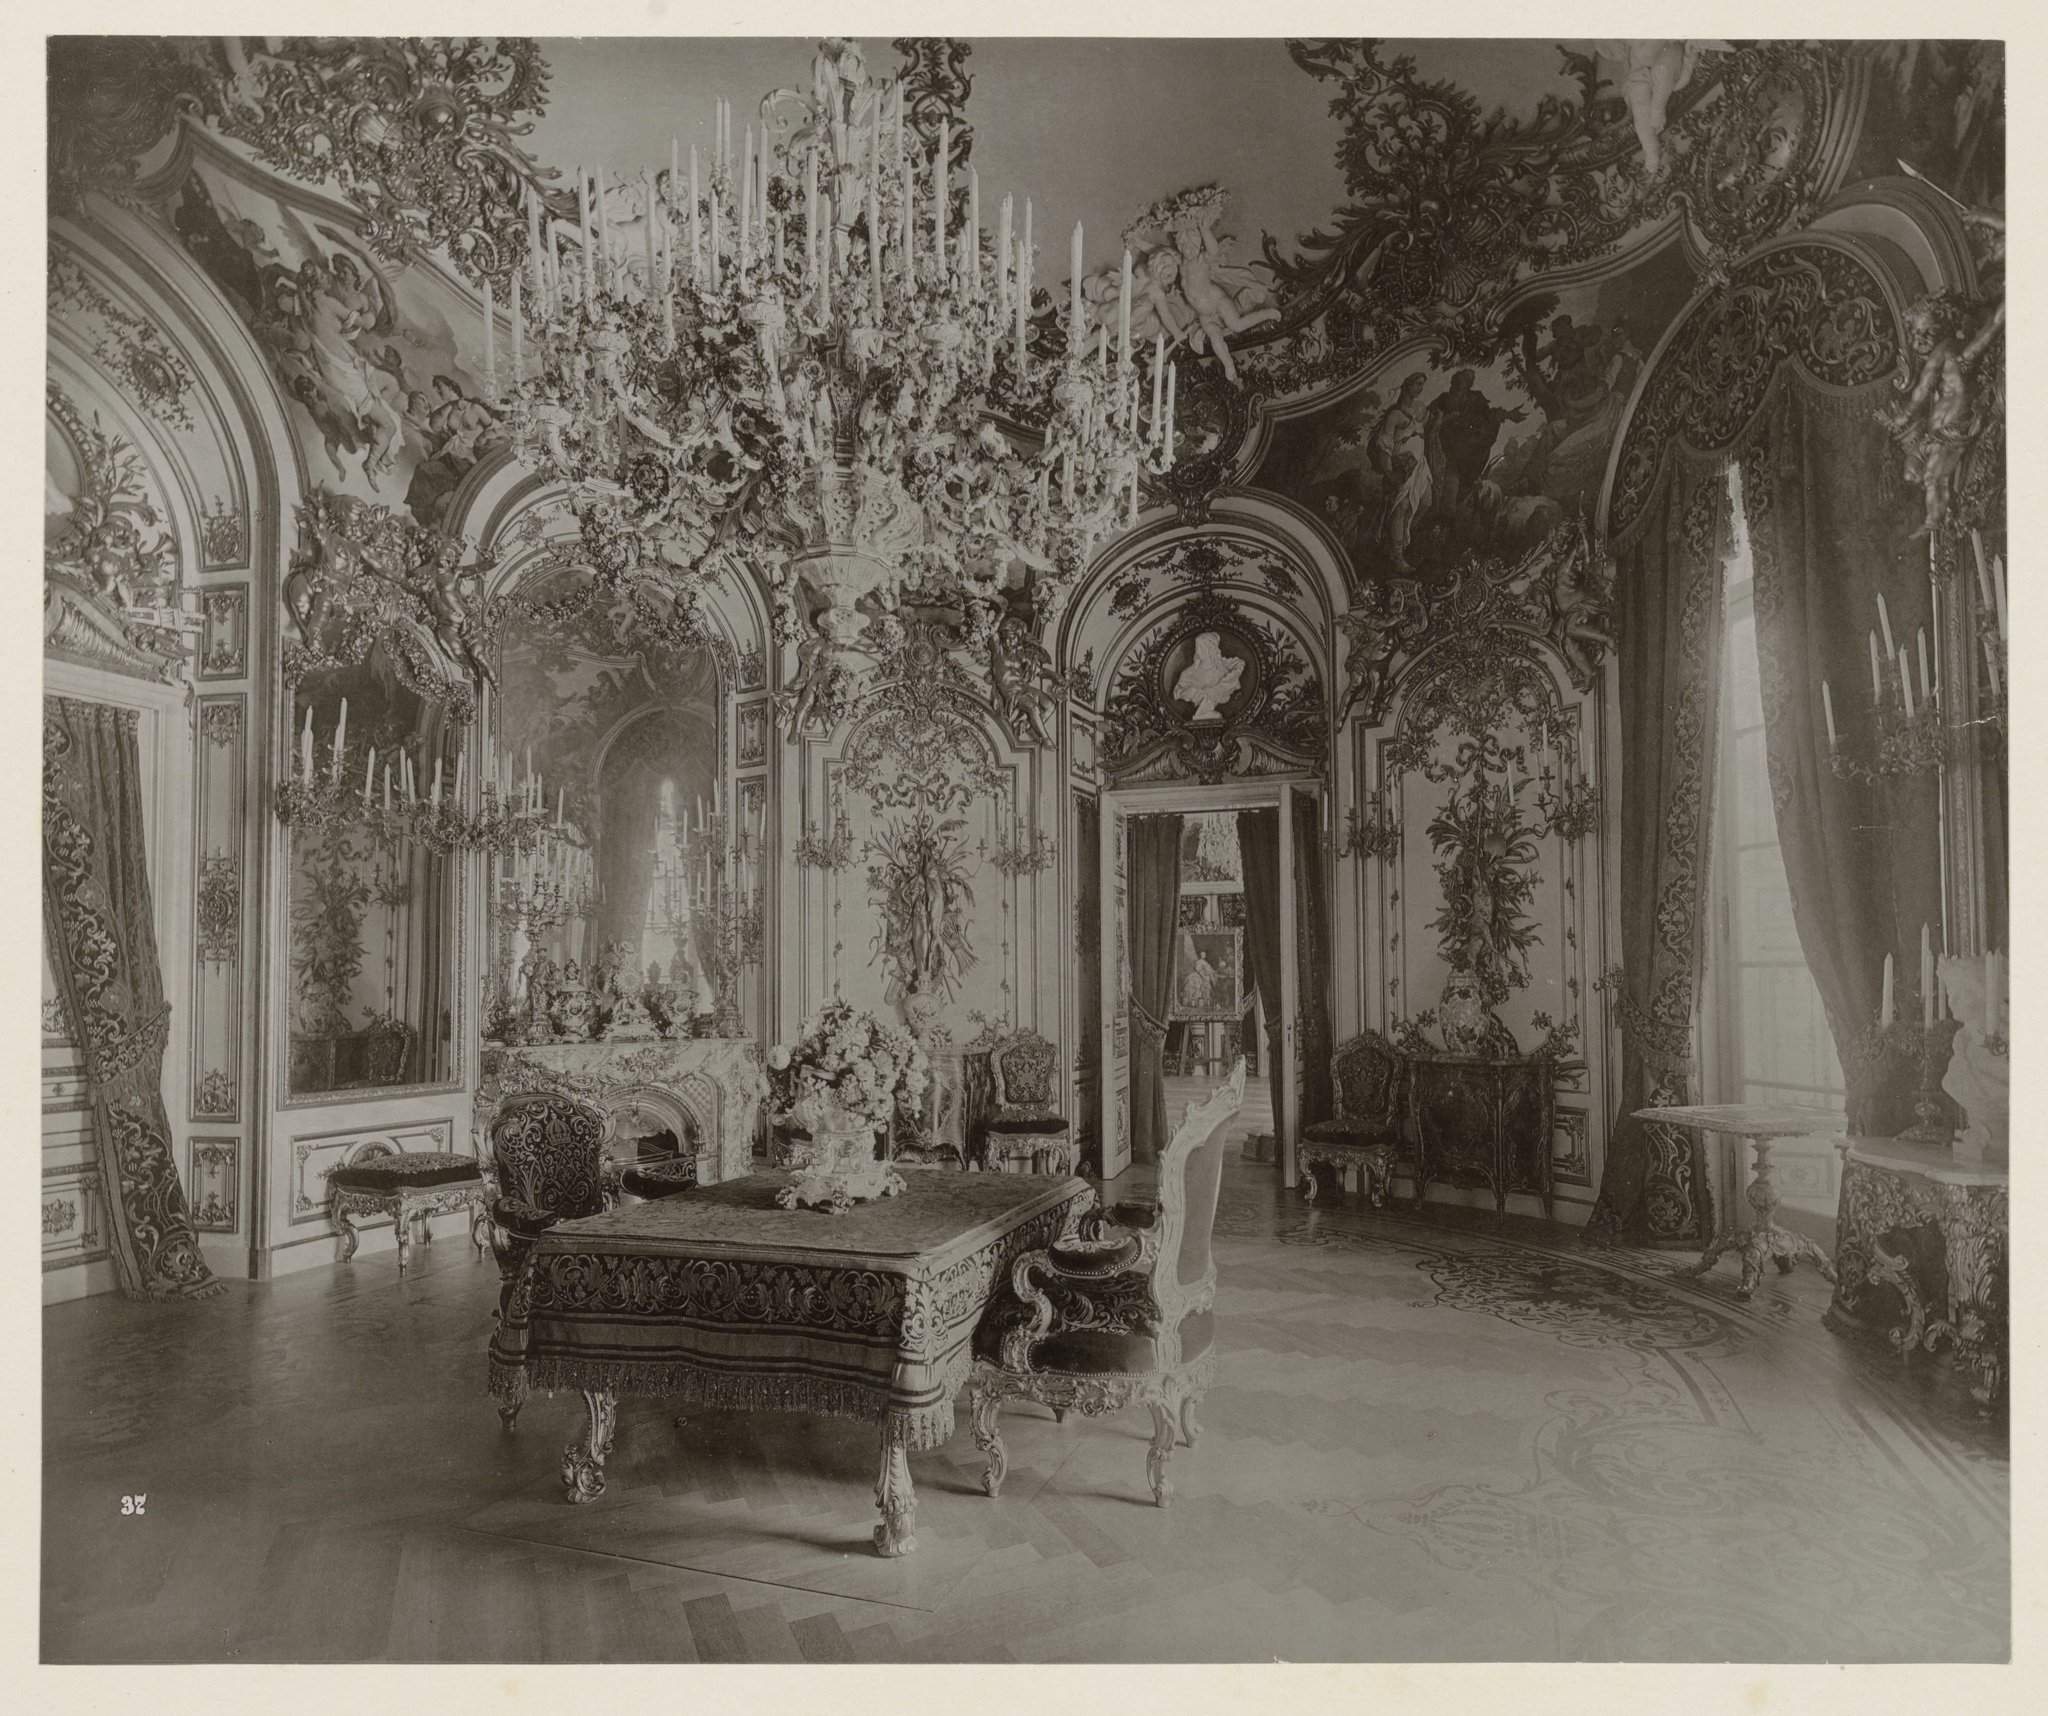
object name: photomechanical print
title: Paleisinterieur met grote kandelaar en beschilderde wanden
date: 1887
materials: cardboard, paper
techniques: photograph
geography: herrenchiemsee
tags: palace - aa - civic architecture: inside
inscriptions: inscription: ‘München’, number: ‘37’, check stamp: ‘Jos. Albert/ München’, date: ‘1887’